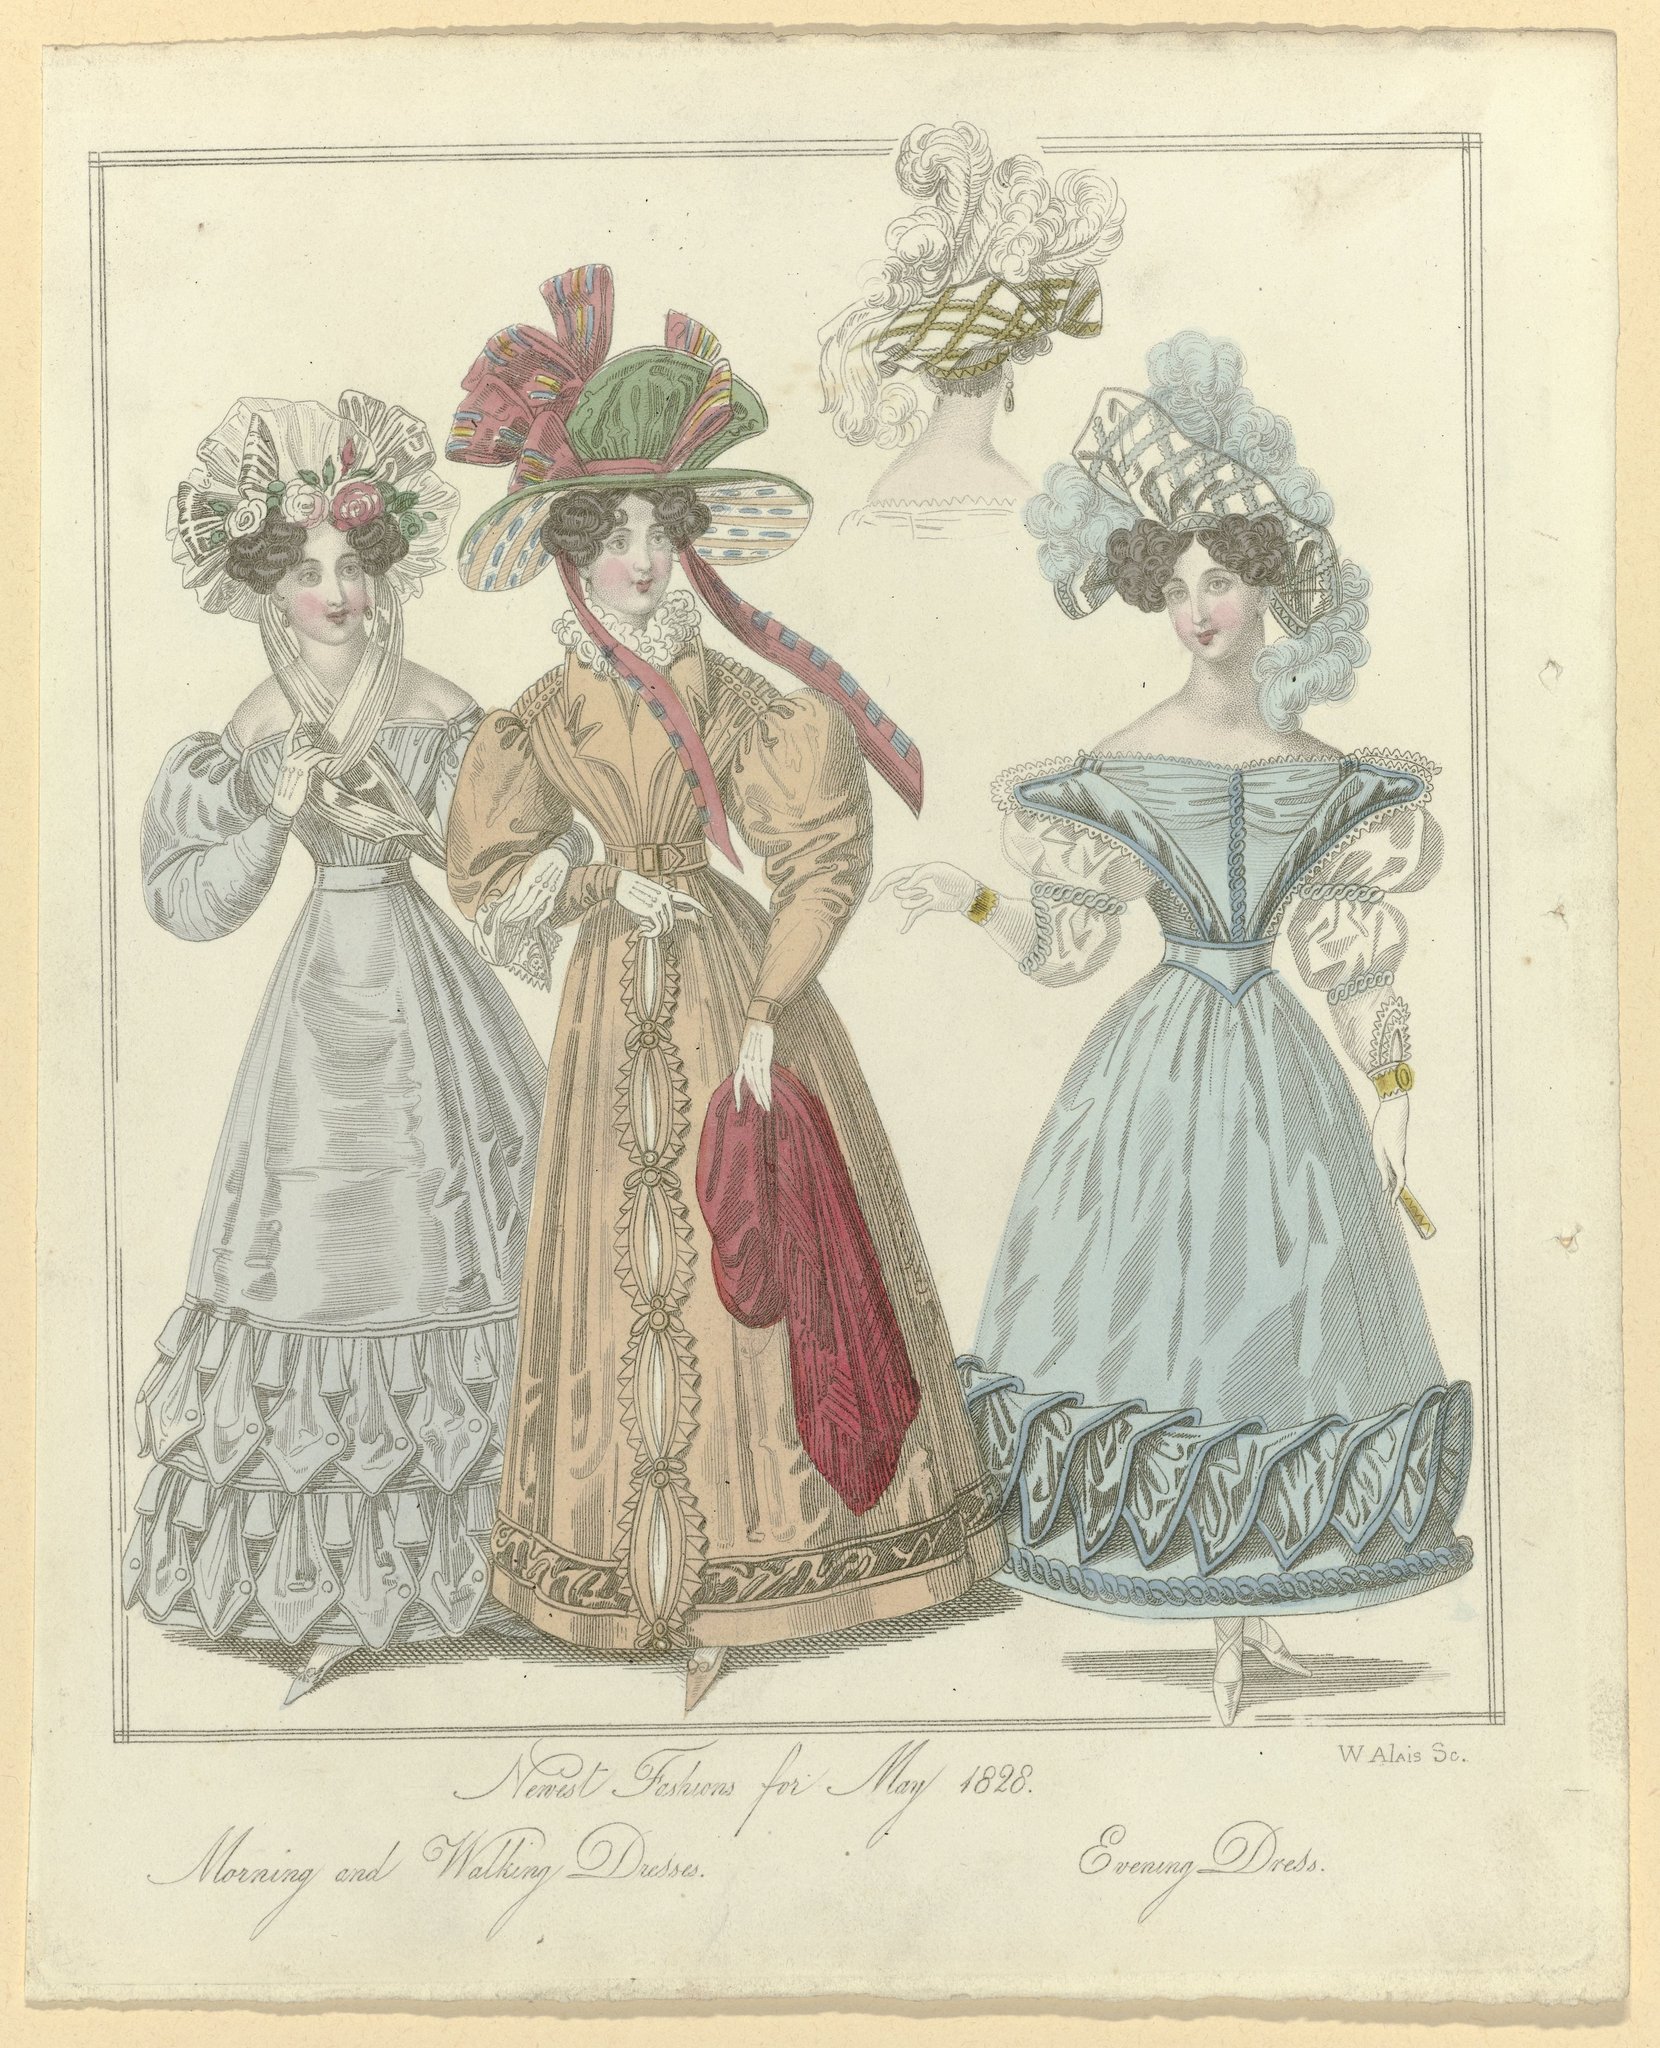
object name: fashion print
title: The World of Fashion, may 1828 : Morning and Walking Dresses (...)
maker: william wolfe alais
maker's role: print maker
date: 1828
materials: paper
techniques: etching, hand coloring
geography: london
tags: ear-rings (+ women's clothes), dress, gown: evening dress (+ women's clothes), clothing for the upper part of the body (shawl) (+ women's clothes), dress, gown: morning dress (+ women's clothes), dress, gown: walking dress (+ women's clothes), head-gear: beret (+ women's clothes), head-gear: cap (+ women's clothes), fashion plates, head-gear: hat (+ women's clothes), fan (+ women's clothes), bracelet, wristlet (+ women's clothes)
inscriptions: caption: ‘Newest Fashions for May 1828. / Morning and Walking Dresses. Evening Dress.’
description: Nieuwste modes voor mei 1828. Drie vrouwen in een ochtendjapon, wandeljapon en avondjapon. Accessoires: muts, hoed met striklinten, baret(?) met veren, handschoenen, oorbellen, sjaal, waaier, armbanden. Prent uit het modetijdschrift The World of Fashion (1824-1891).